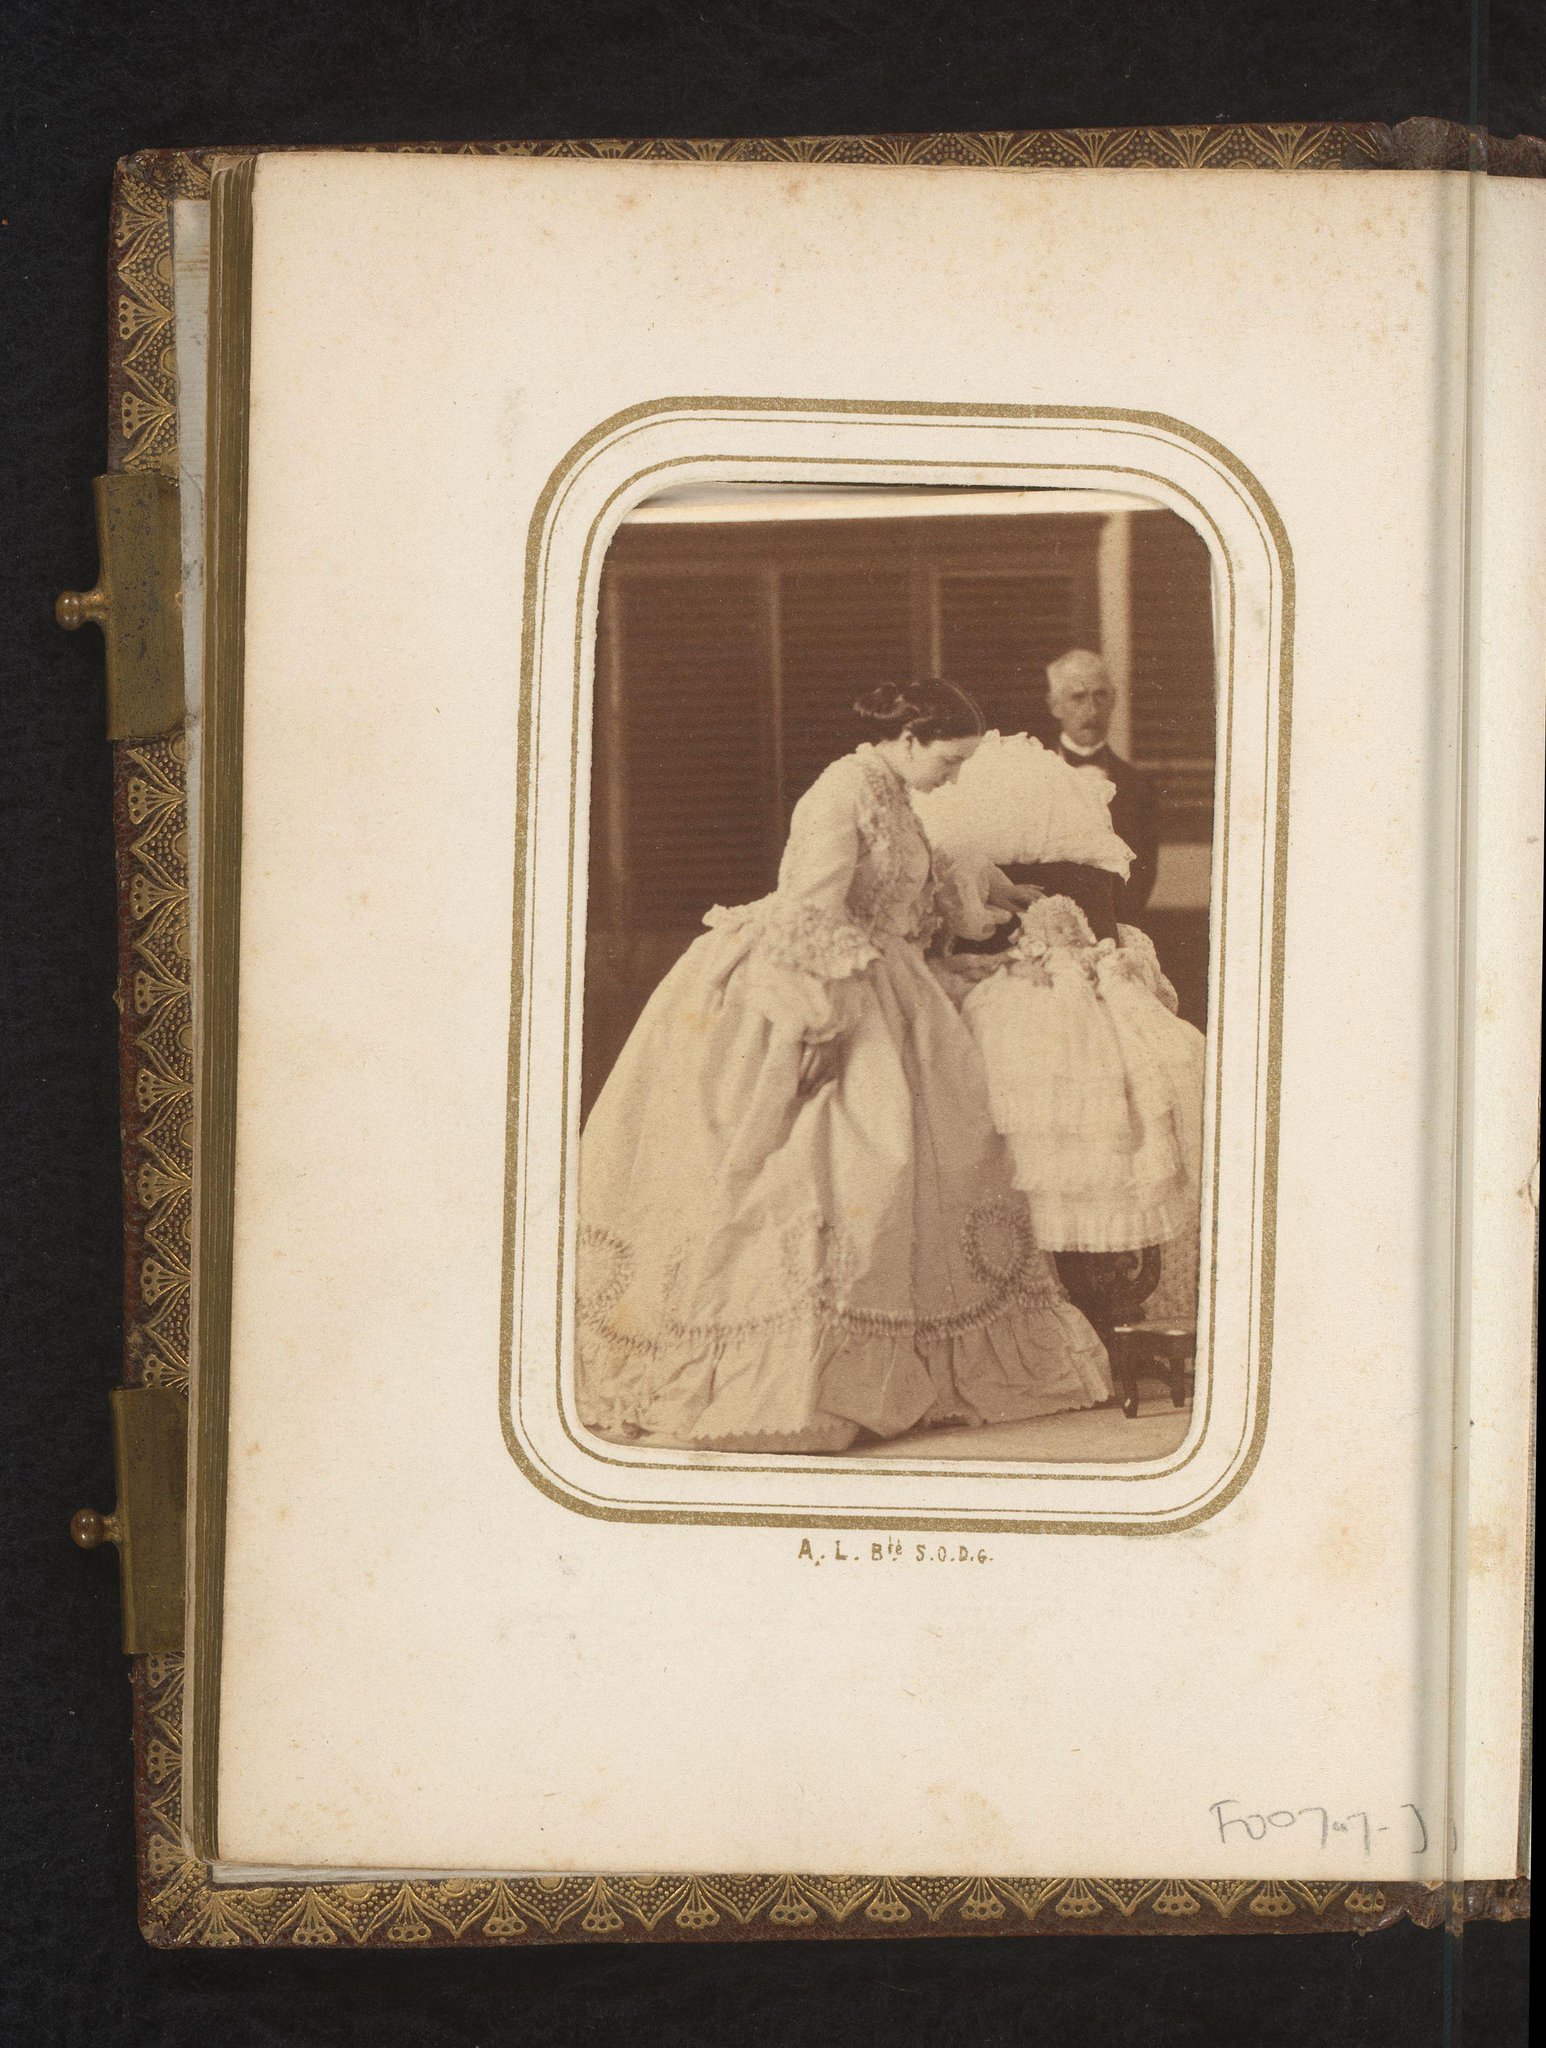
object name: carte de visite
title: Staande vrouw bij een baby in doopjurk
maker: Anonymous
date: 1803-1861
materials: cardboard, photographic support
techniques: albumen print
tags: adult woman, historical persons, infant, baby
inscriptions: date: ‘Marzo '61’, inscription: ‘A.L. B.te S.C.D.G.’